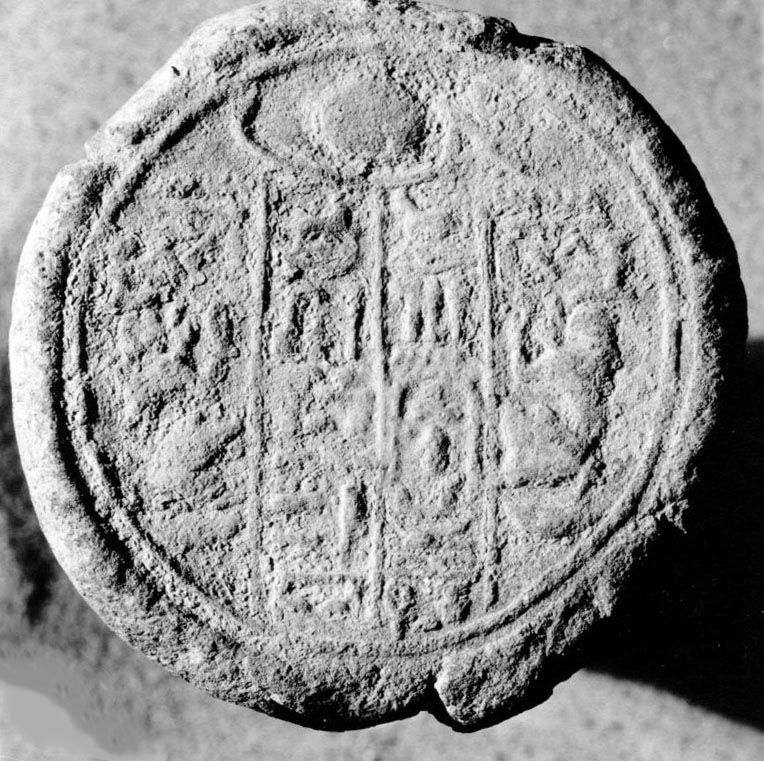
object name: cone, enta, round stamp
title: Funerary Cone of Enta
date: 1550-1295 BCE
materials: pottery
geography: egypt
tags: hieroglyphs